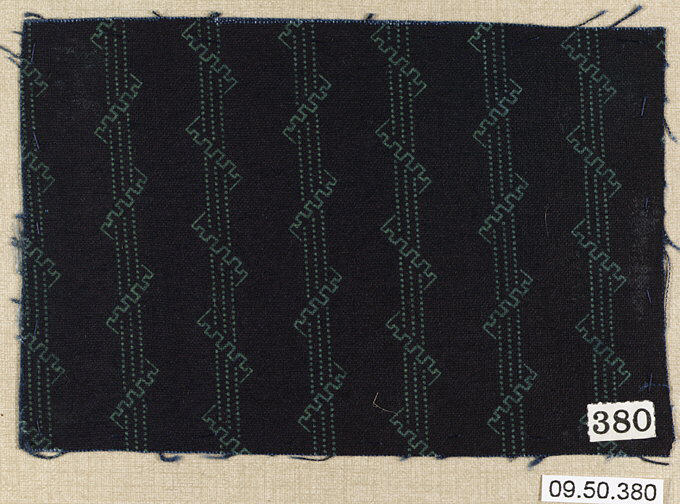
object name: piece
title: Piece (one of 116)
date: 1801-1900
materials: cotton